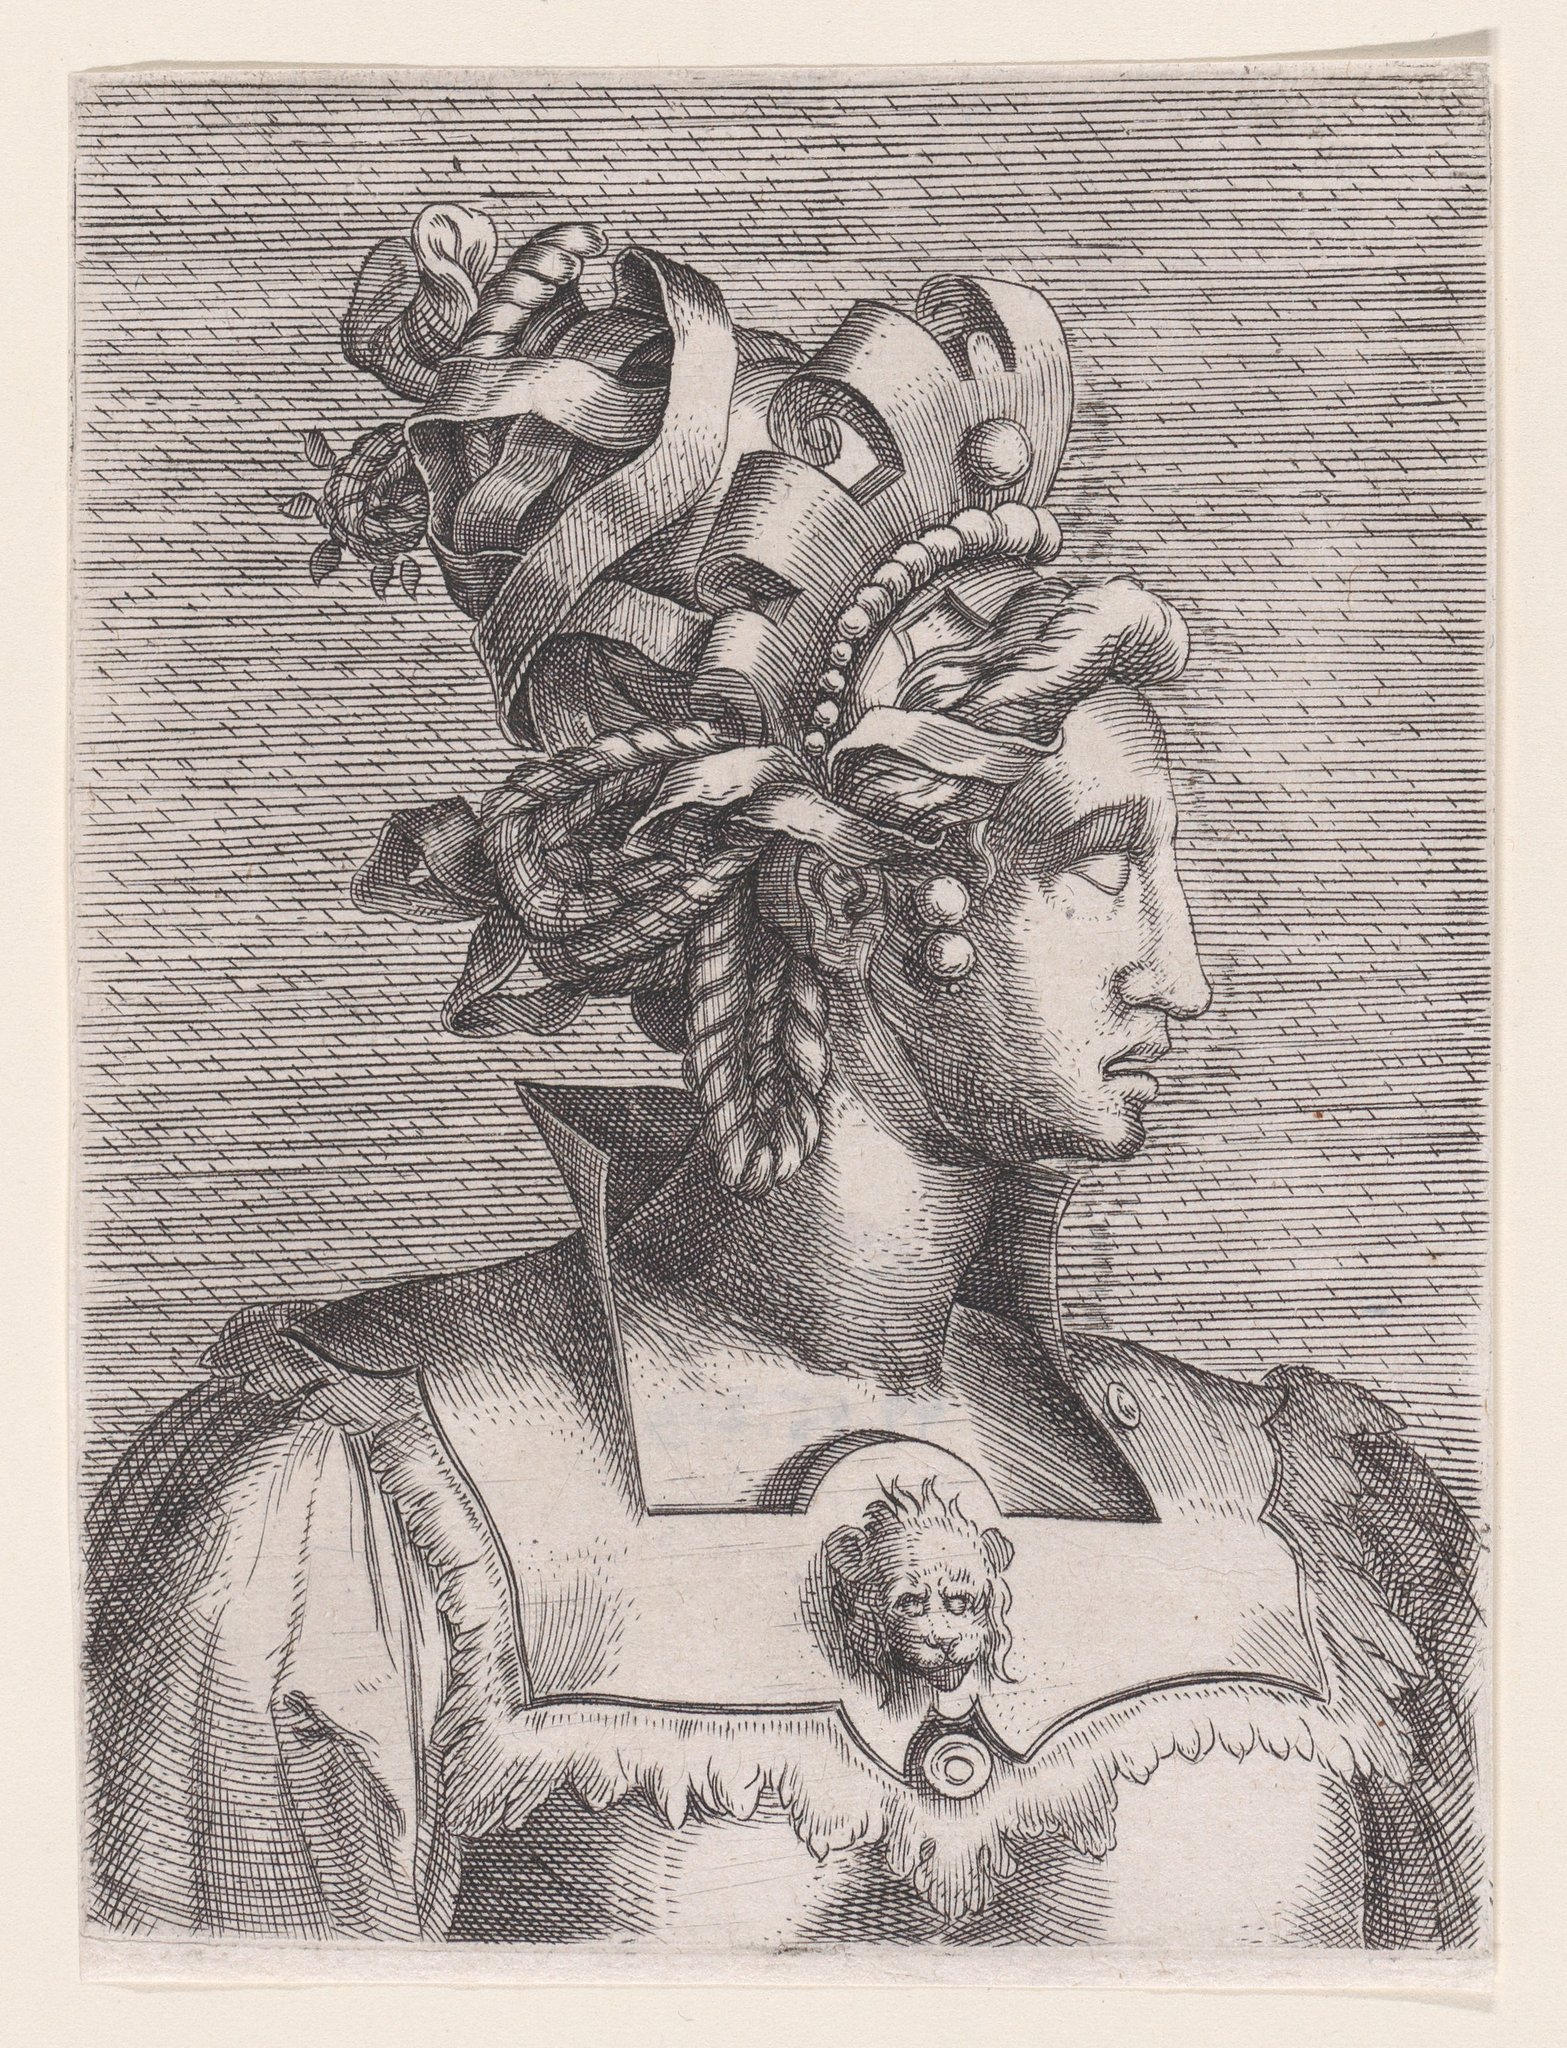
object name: print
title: Bust of a Woman Wearing a Fantastic Head-dress and Mask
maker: rené boyvin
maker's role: artist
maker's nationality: french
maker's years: 1525-1598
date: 1525-1600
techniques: etching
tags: masks,women,headdresses